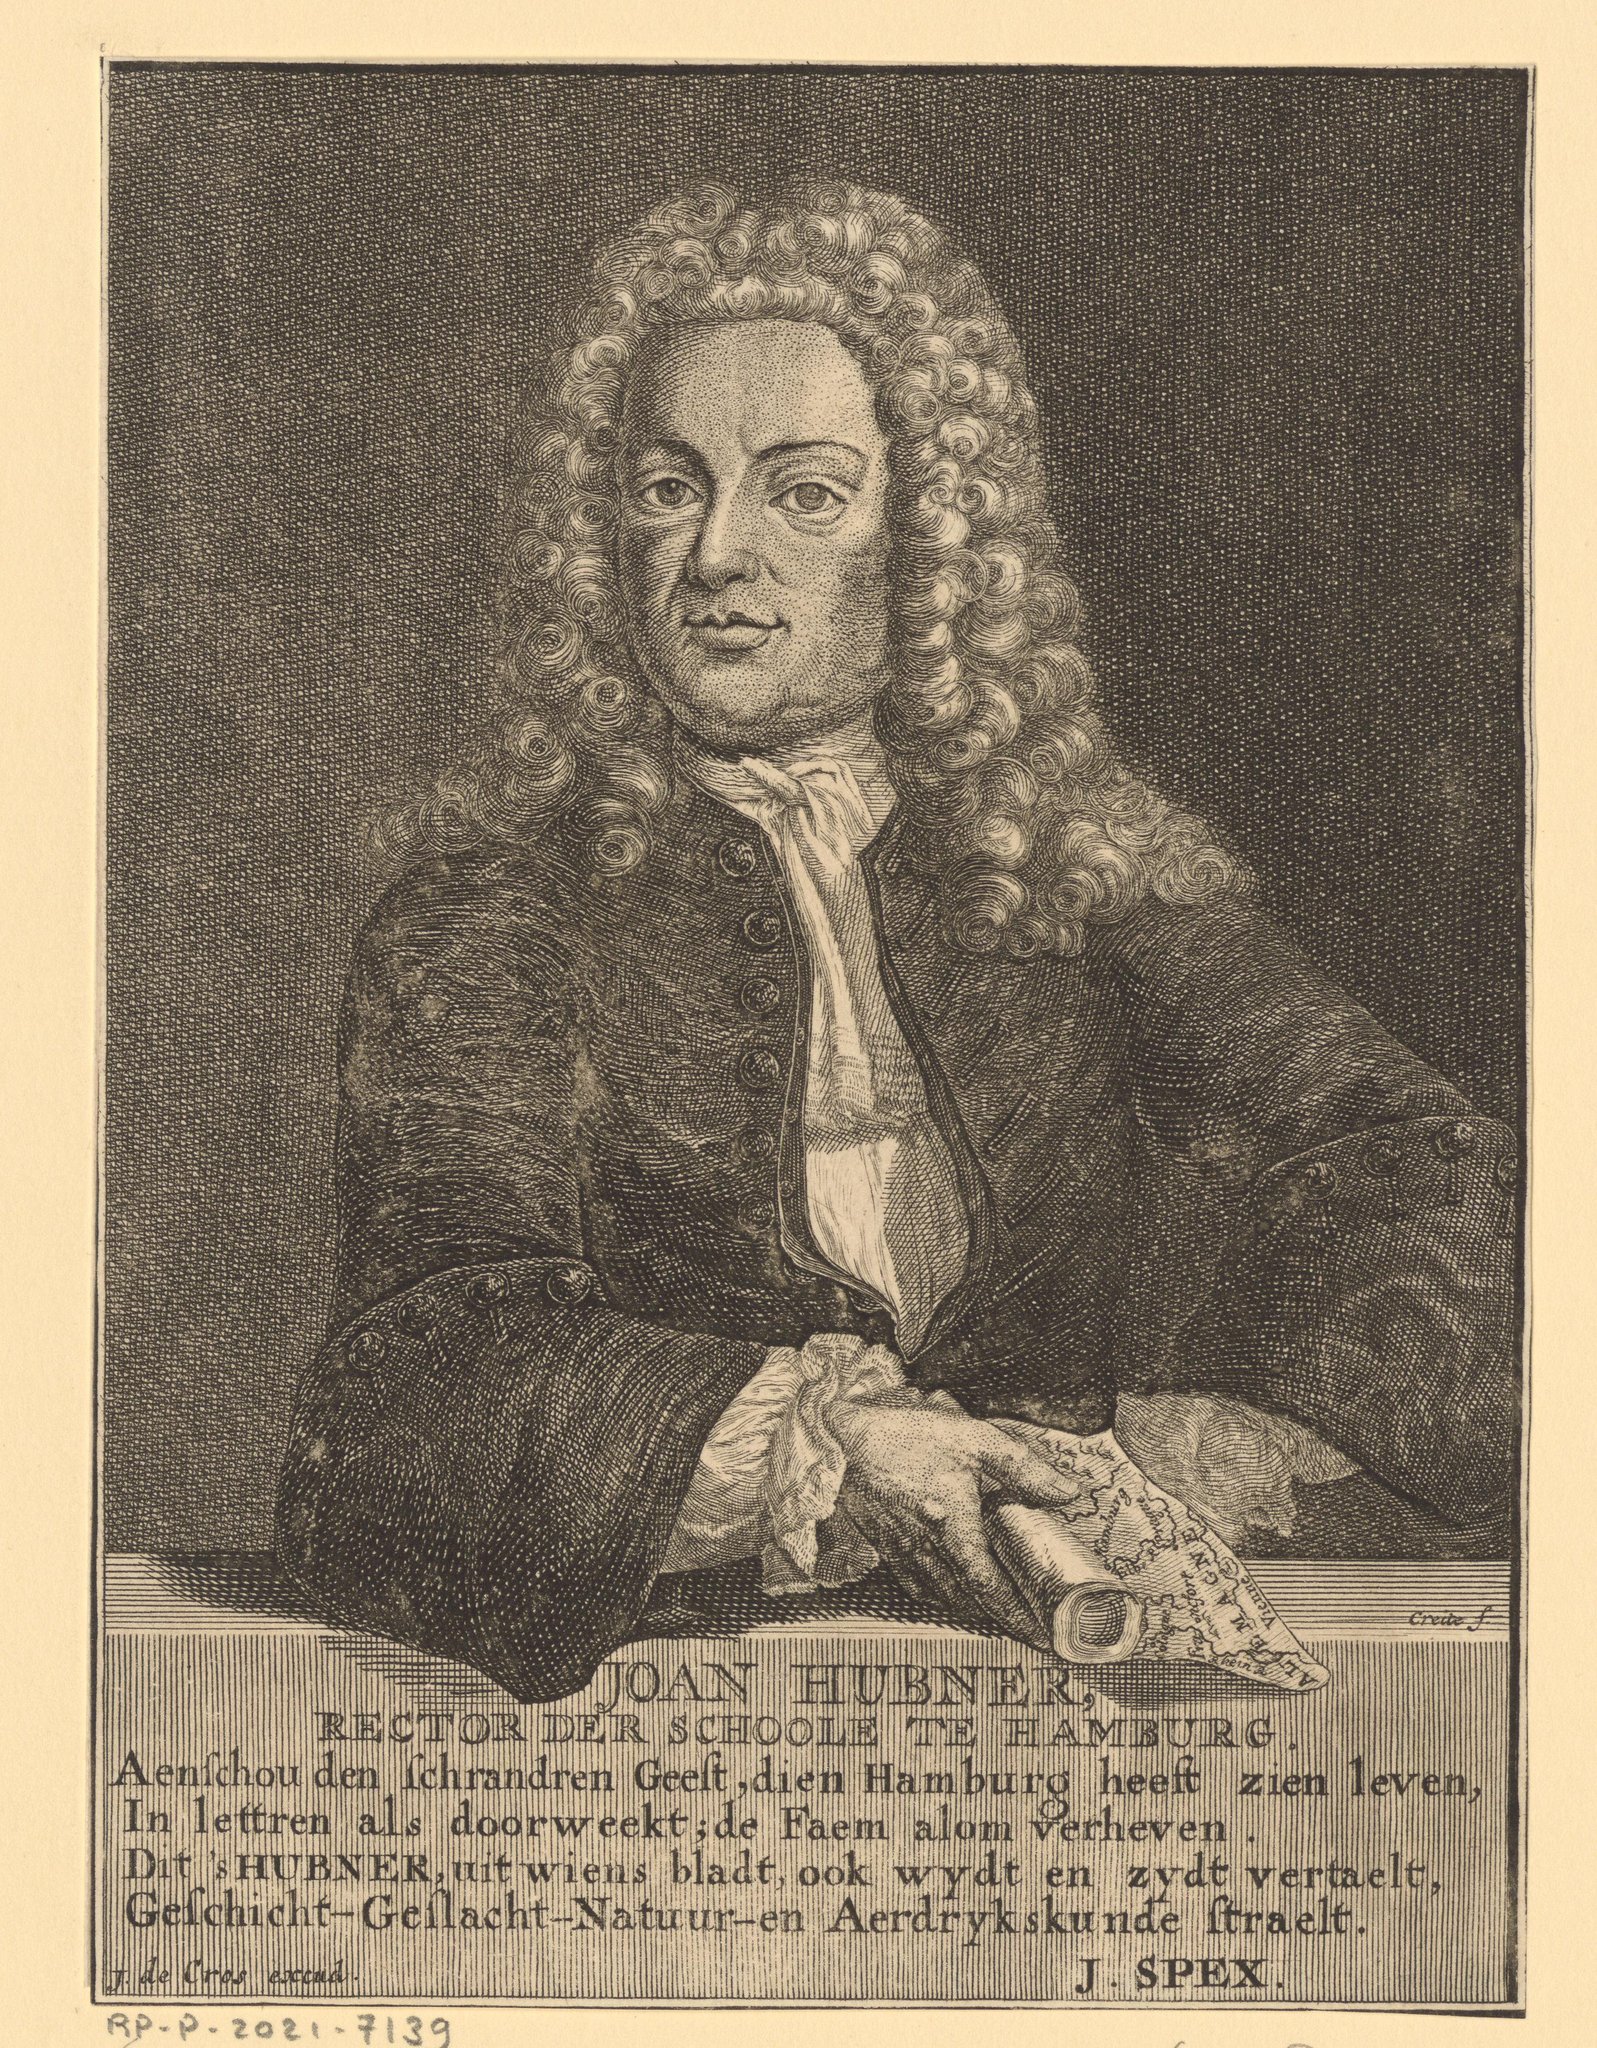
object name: print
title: Portret van Johann Hübner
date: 1739-1758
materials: paper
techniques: engraving, etching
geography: the hague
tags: publisher, johann hübner, scholar, philosopher, historical persons, portrait of a writer